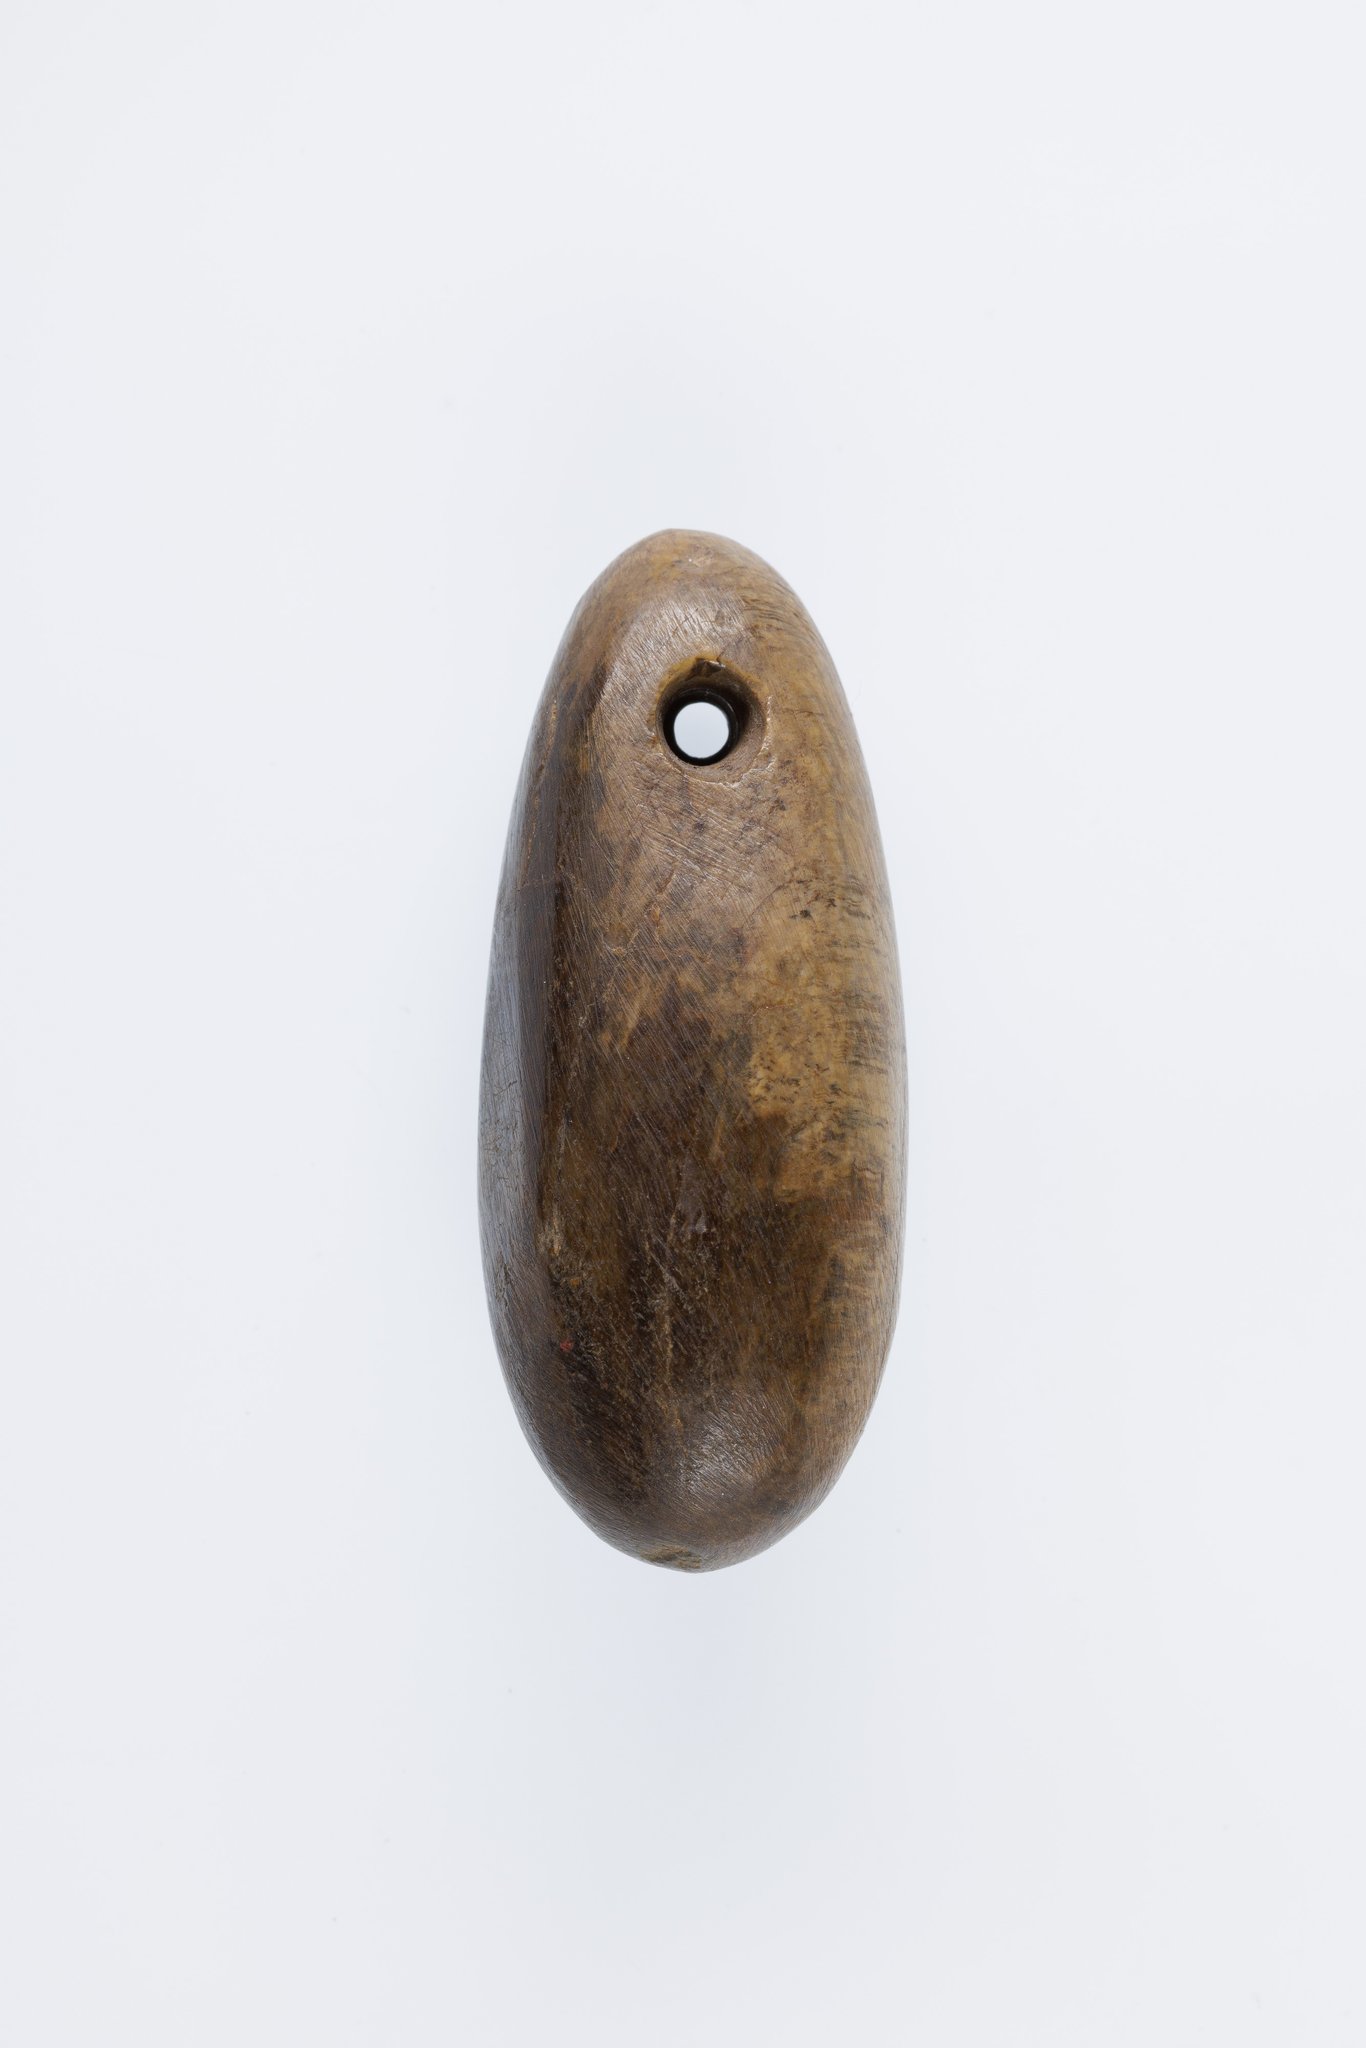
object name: pendant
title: Drop pendant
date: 3850-3500 BCE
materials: ivory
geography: egypt